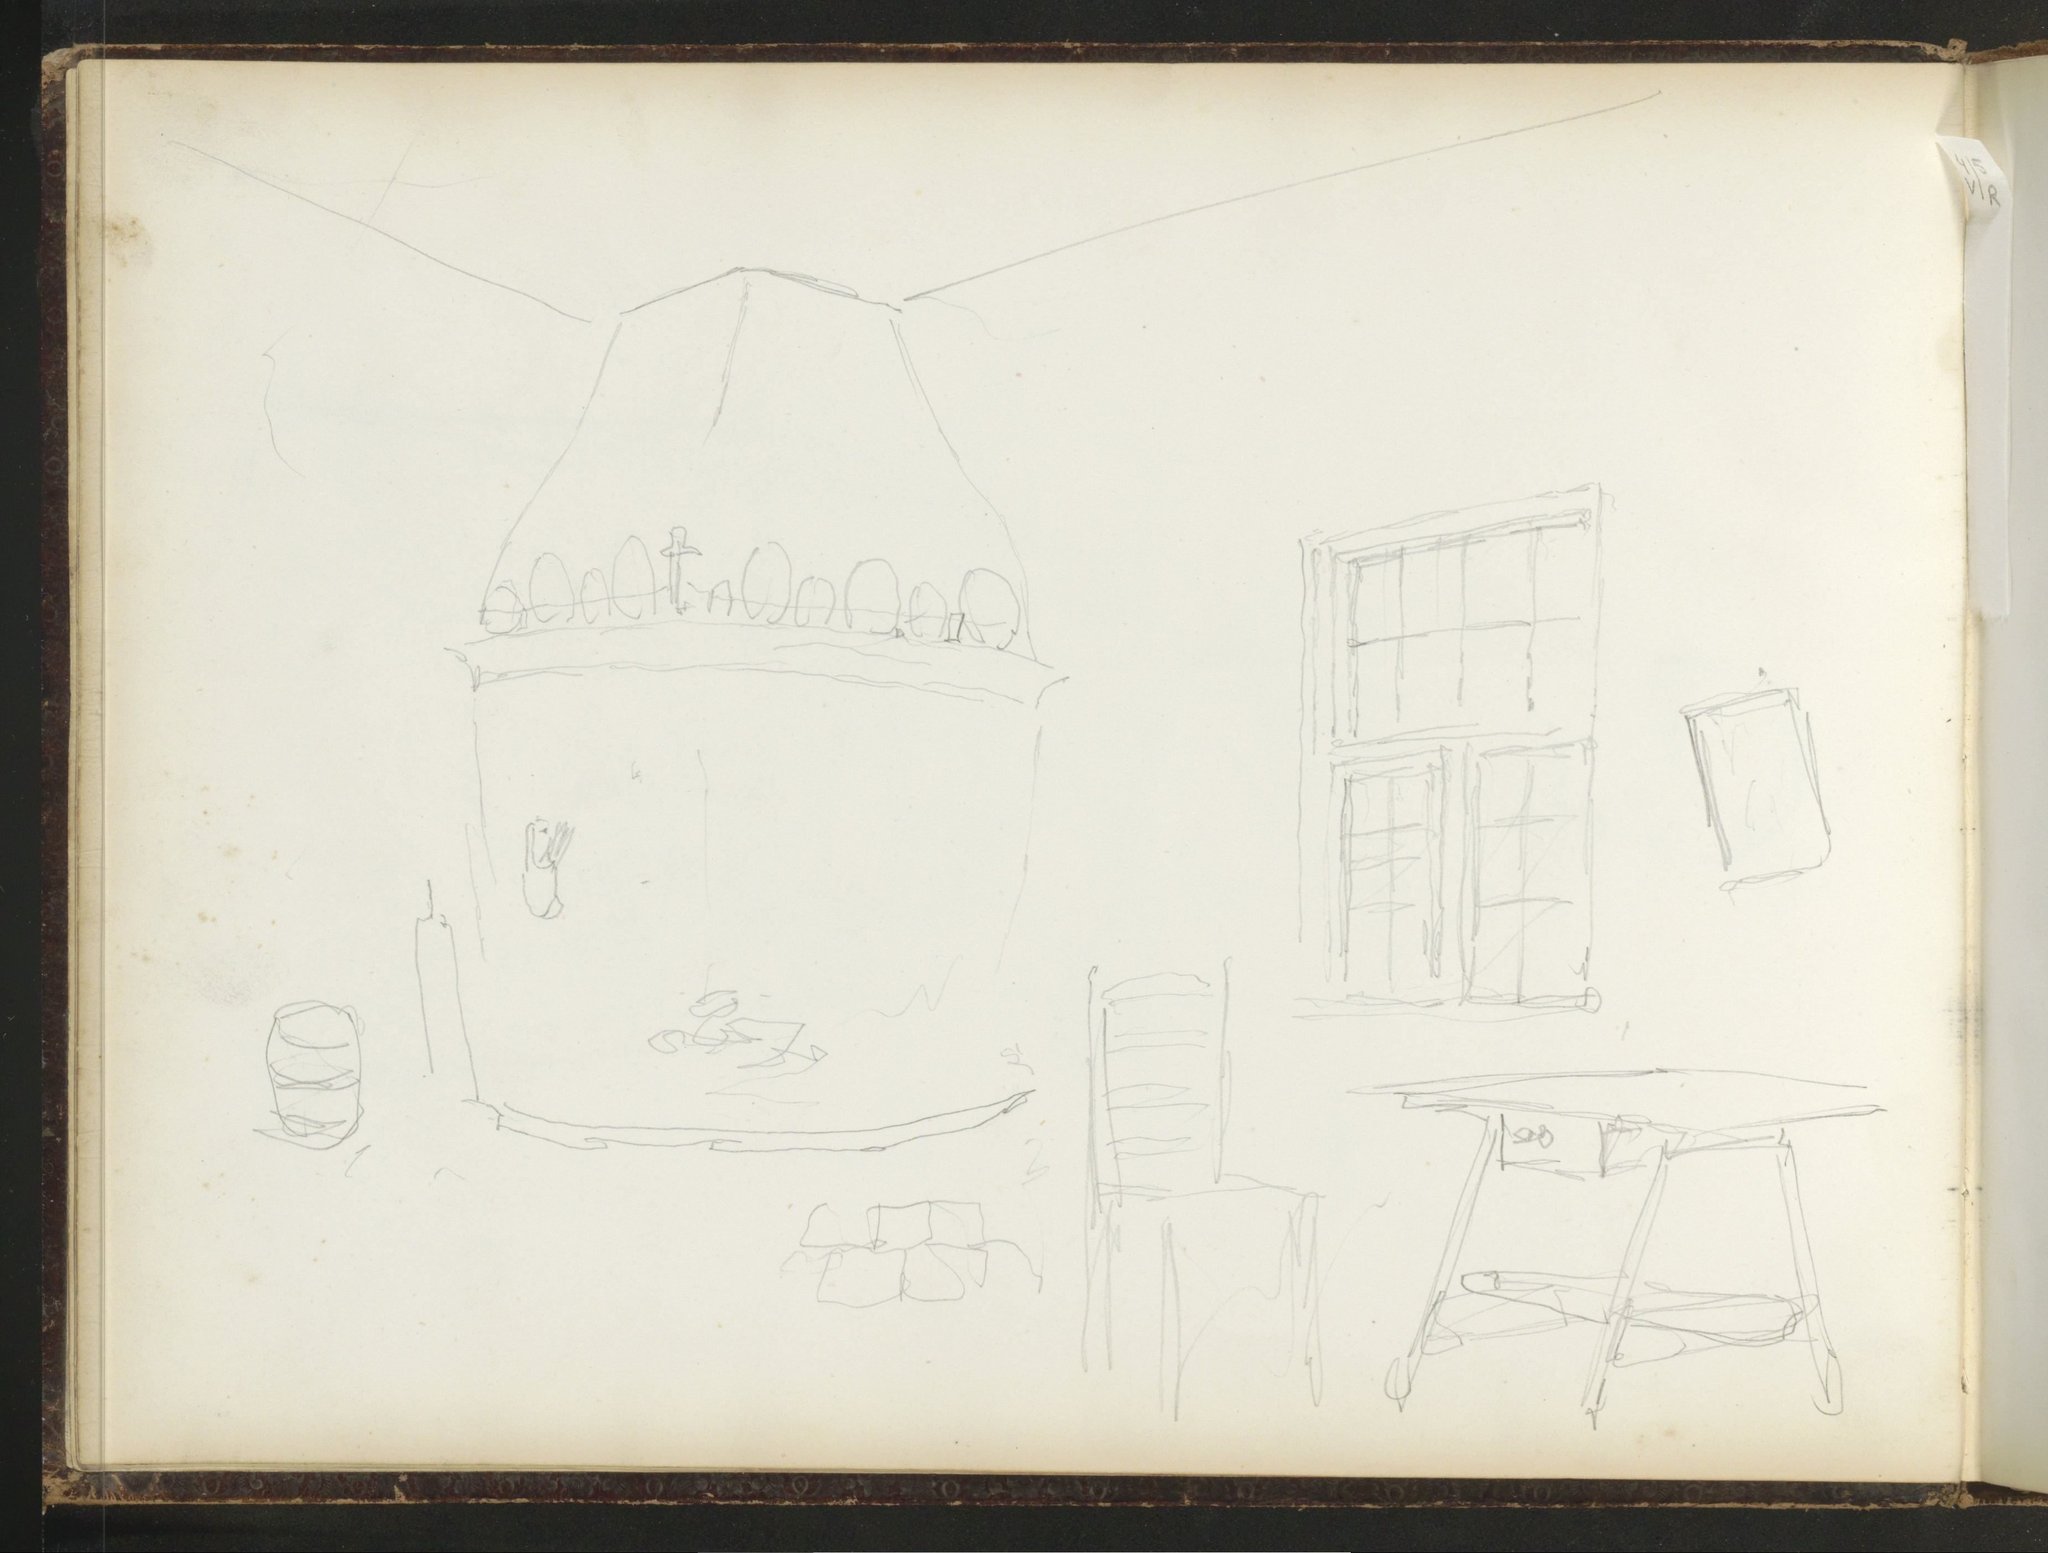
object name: sketchbook leaf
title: Studieblad, onder andere met een tekentafel, stoel en ramen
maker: reinier craeyvanger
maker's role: draughtsman, print maker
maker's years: 1812-1880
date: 1822-1880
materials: paper, pencil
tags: chimney, window, table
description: Tevens een studie van een haard met een schouw en borden. Blad 4 verso uit een schetsboek met 45 bladen.